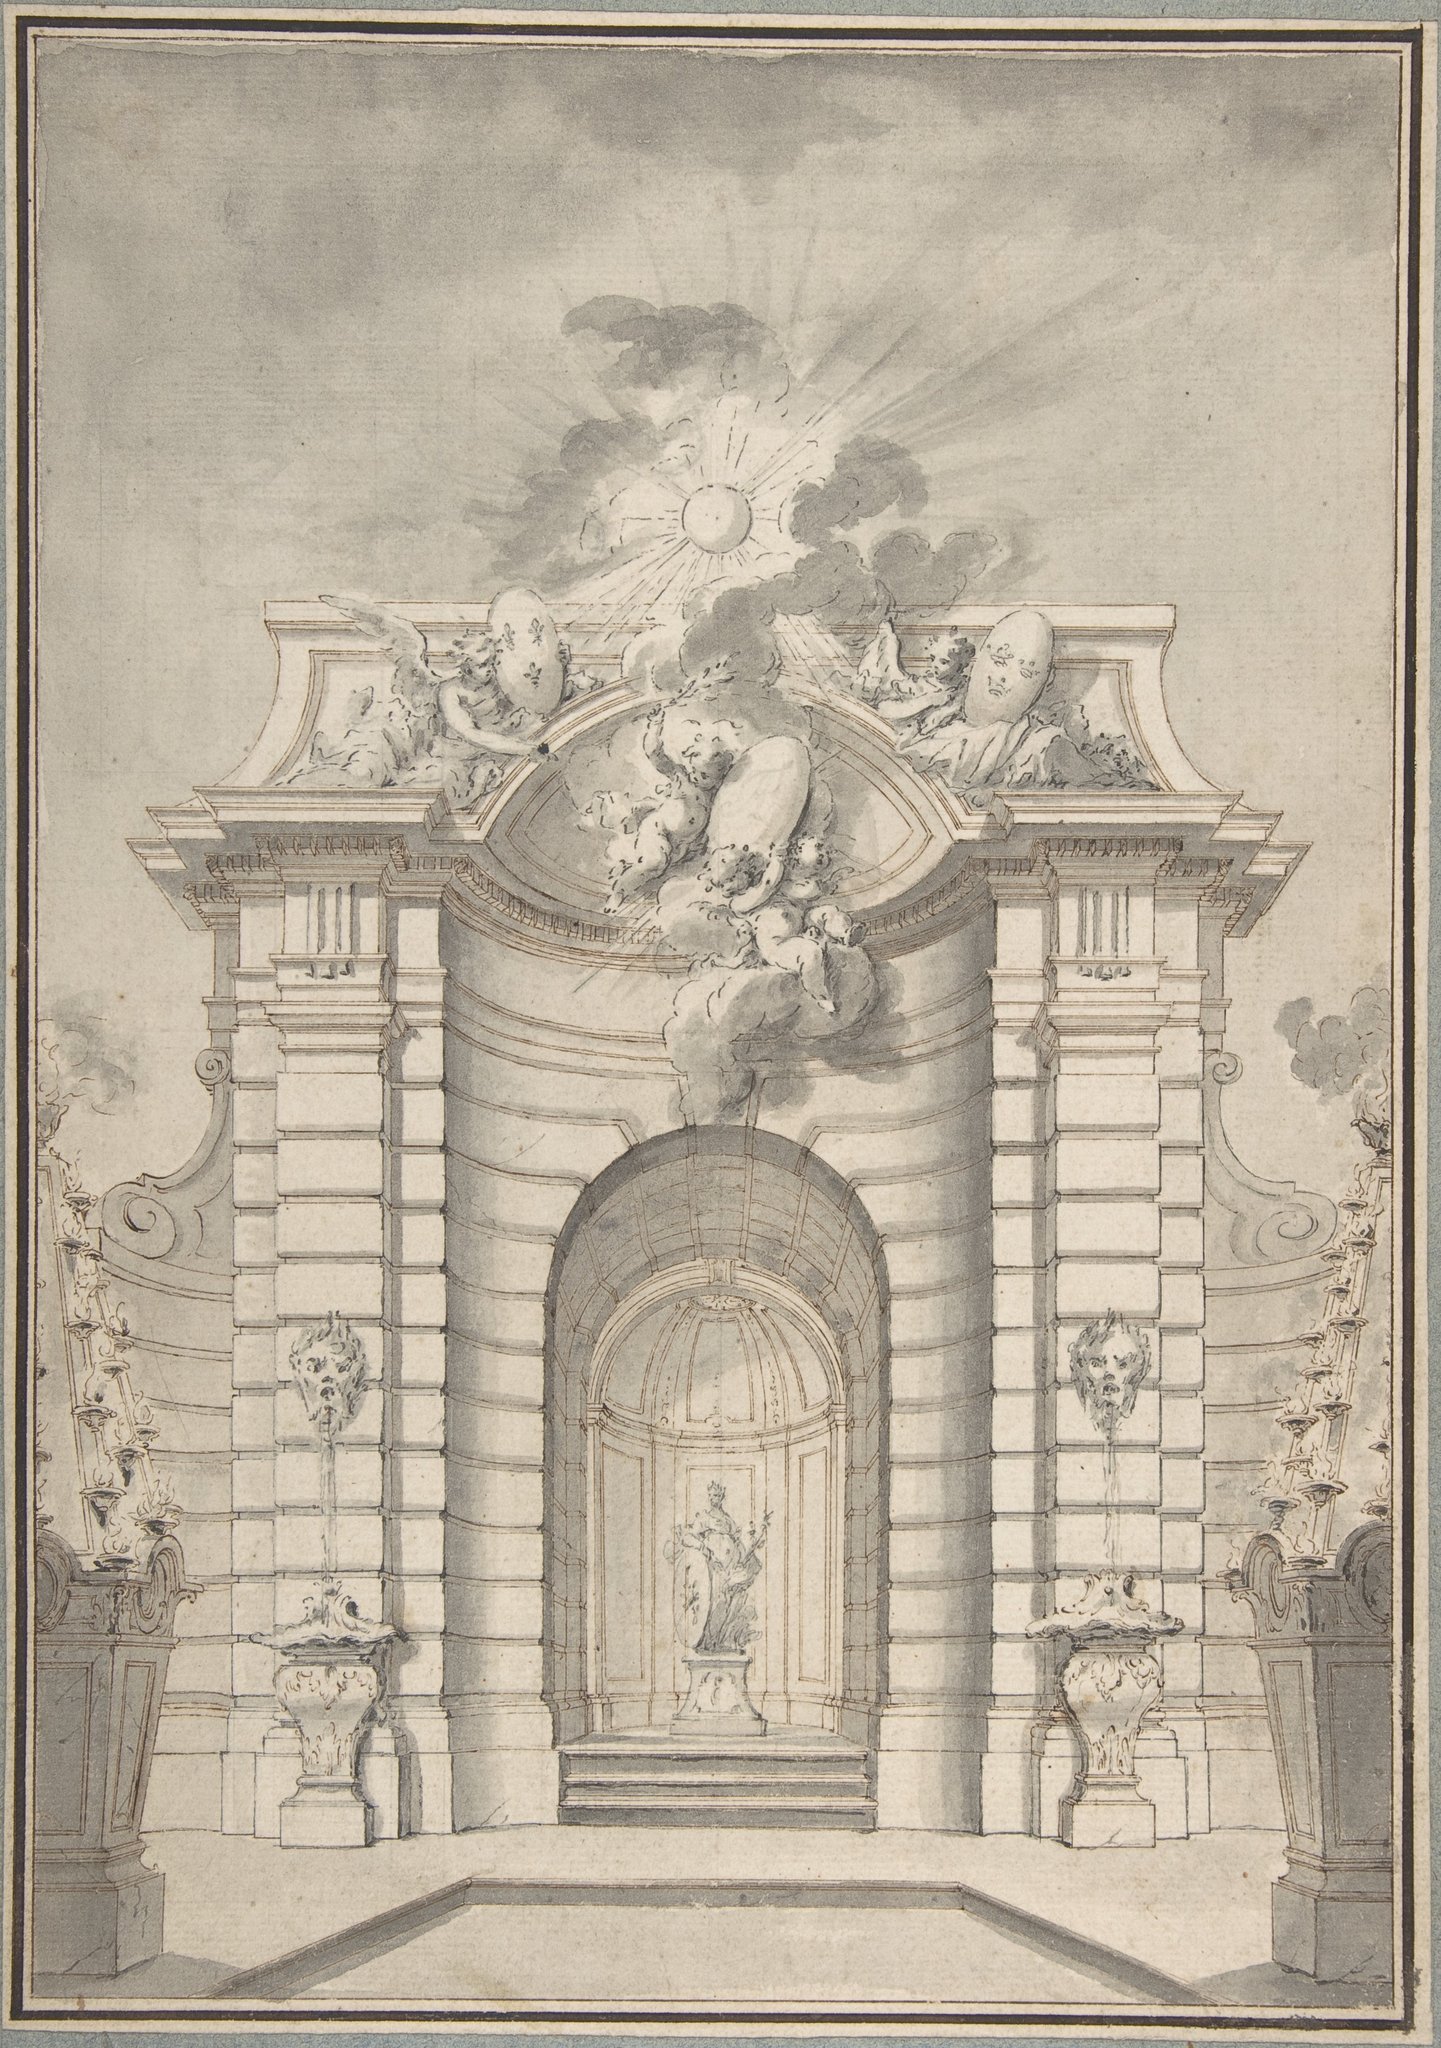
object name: drawing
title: Design for Festival Architecture for an Entry into Paris for the King of Sweden, Fredrerick I of Hesse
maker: guillaume thomas raphaël taraval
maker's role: artist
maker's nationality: french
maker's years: 1701-1750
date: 1701-1800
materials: ink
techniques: brush, pen, wash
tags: architecture